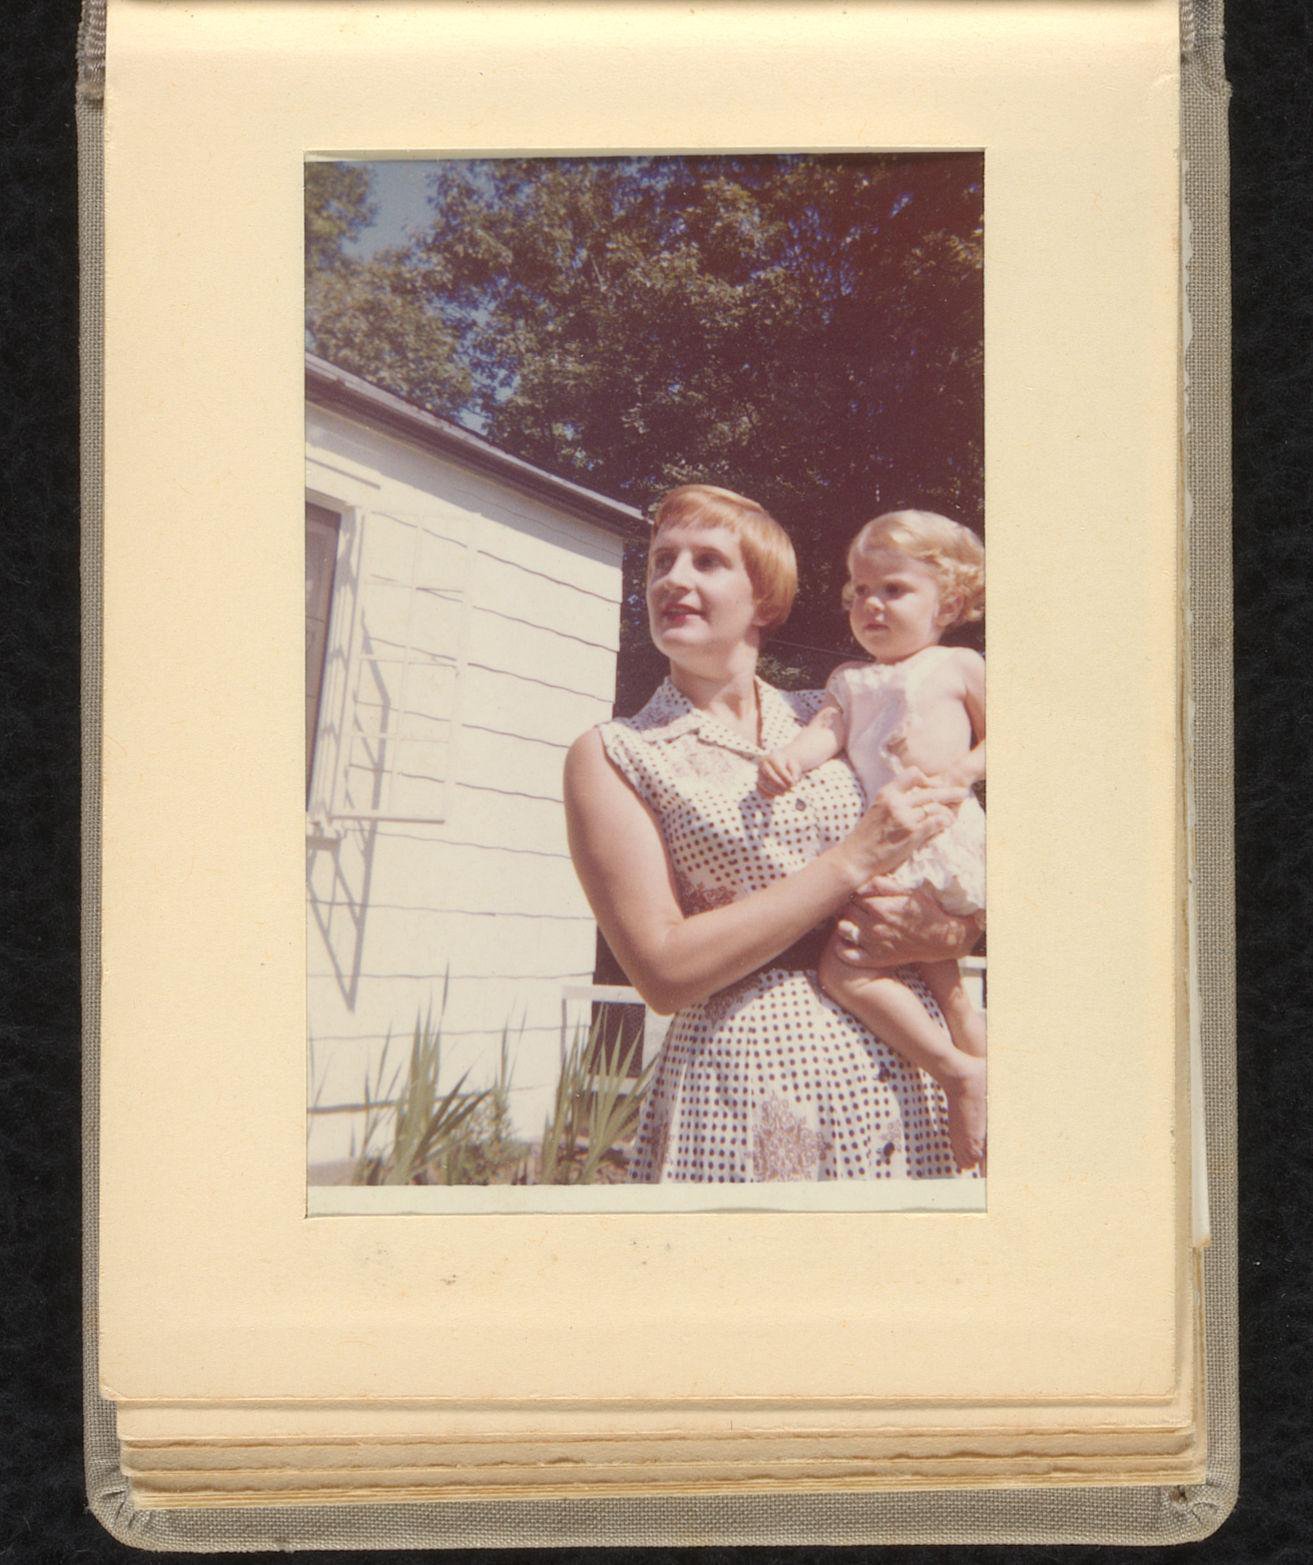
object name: photograph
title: Isabel Wachenheimer in de tuin met een onbekend meisje, juli 1960, Verenigde Staten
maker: isabel wachenheimer-elon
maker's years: 1928-2010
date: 1907-1960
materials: paper, photographic support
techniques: gelatin silver print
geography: united states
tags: leiden, isabel wachenheimer-elon, historical persons - bb - woman, united states of america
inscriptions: inscription: ‘July 1960’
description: Albumblad bevat een foto van Isabel Wachenheimer (links) en onbekend meisje (rechts). Onderdeel van het fotoalbum met diverse foto's van de jeugd van Isabel Wachenheimer voor en tijdens de oorlog en diverse momenten van haar volwassen leven na de Tweede Wereldoorlog.